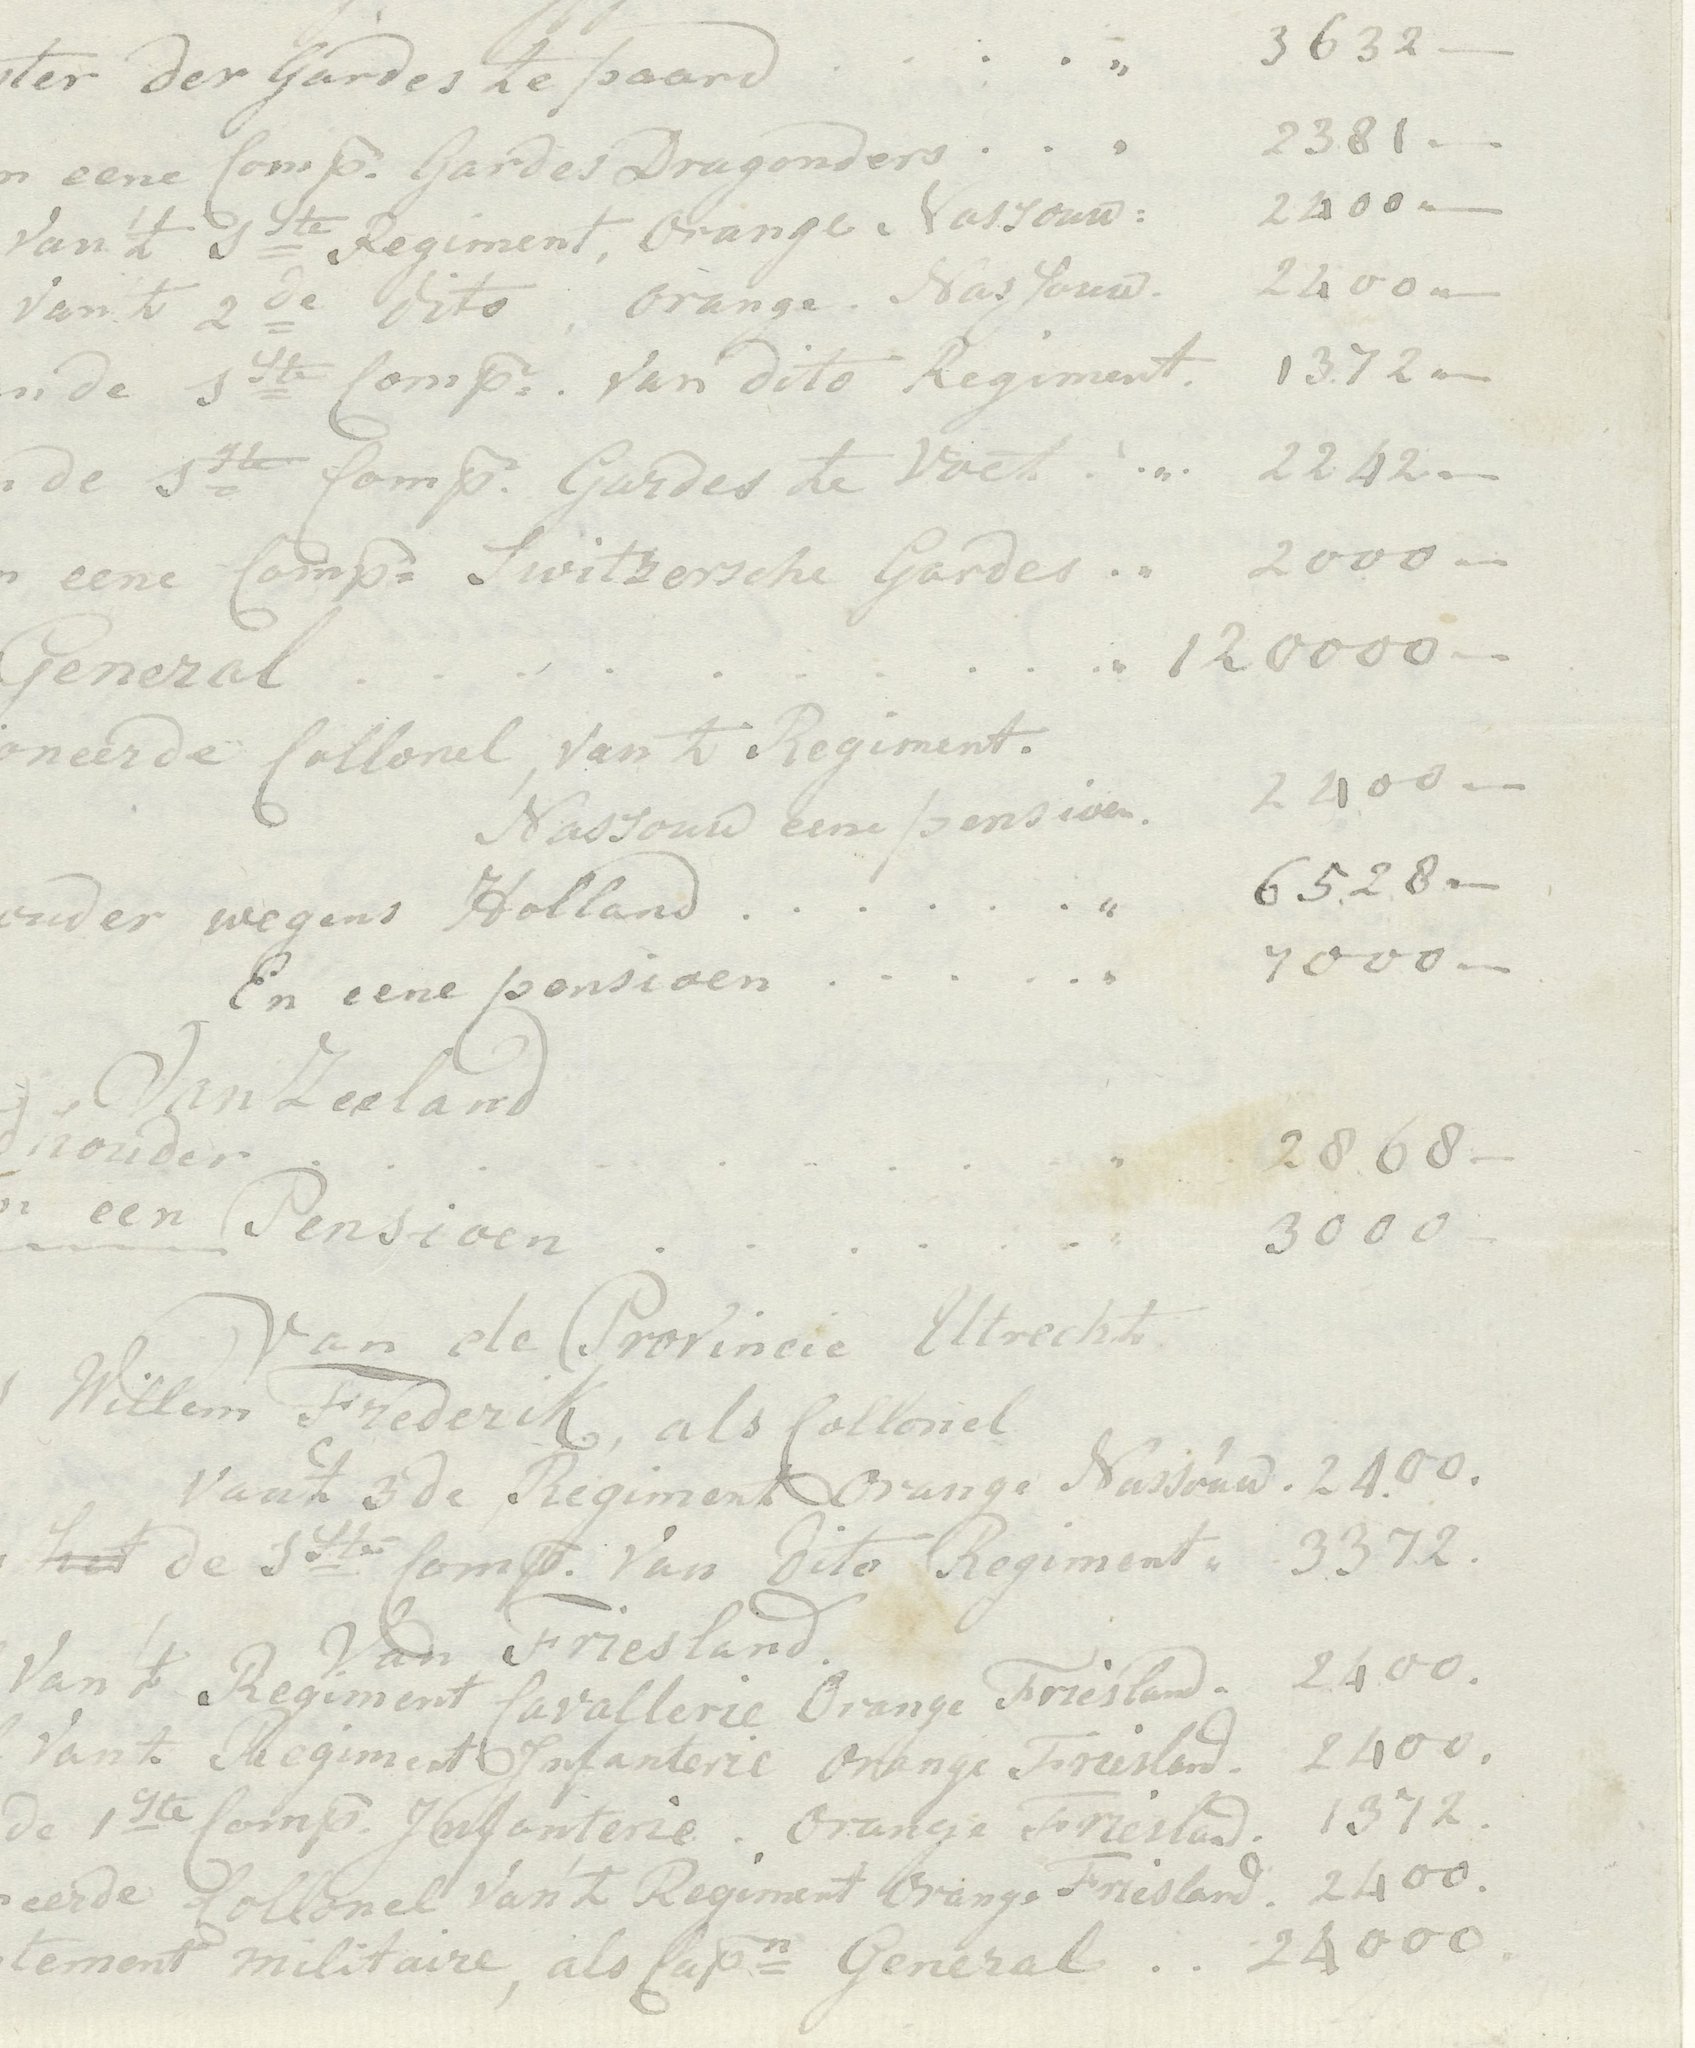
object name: manuscript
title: Overzicht van de inkomsten die Willem V van de staat ontvangt, ca. 1775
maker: Anonymous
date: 1772-1779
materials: paper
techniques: writing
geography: northern netherlands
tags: william v (prince of orange), the hague, berlin, william i of the netherlands, carolina (prinses van oranje-nassau), painter, draughtsman, wilhelmina of prussia (princess of orange), amsterdam, louise (prinses van oranje-nassau)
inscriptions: collector's mark: Lugt 2228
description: Handgeschreven notitie met een overzicht van de inkomsten die stadhouder Willem V (en zijn echtgenote, zuster Carolina en kinderen Frederica Louisa en Willem Frederik) van de afzonderlijke provincies ontvangt, ca. 1775. Dubbelgevouwen blad met tekst op drie zijden.